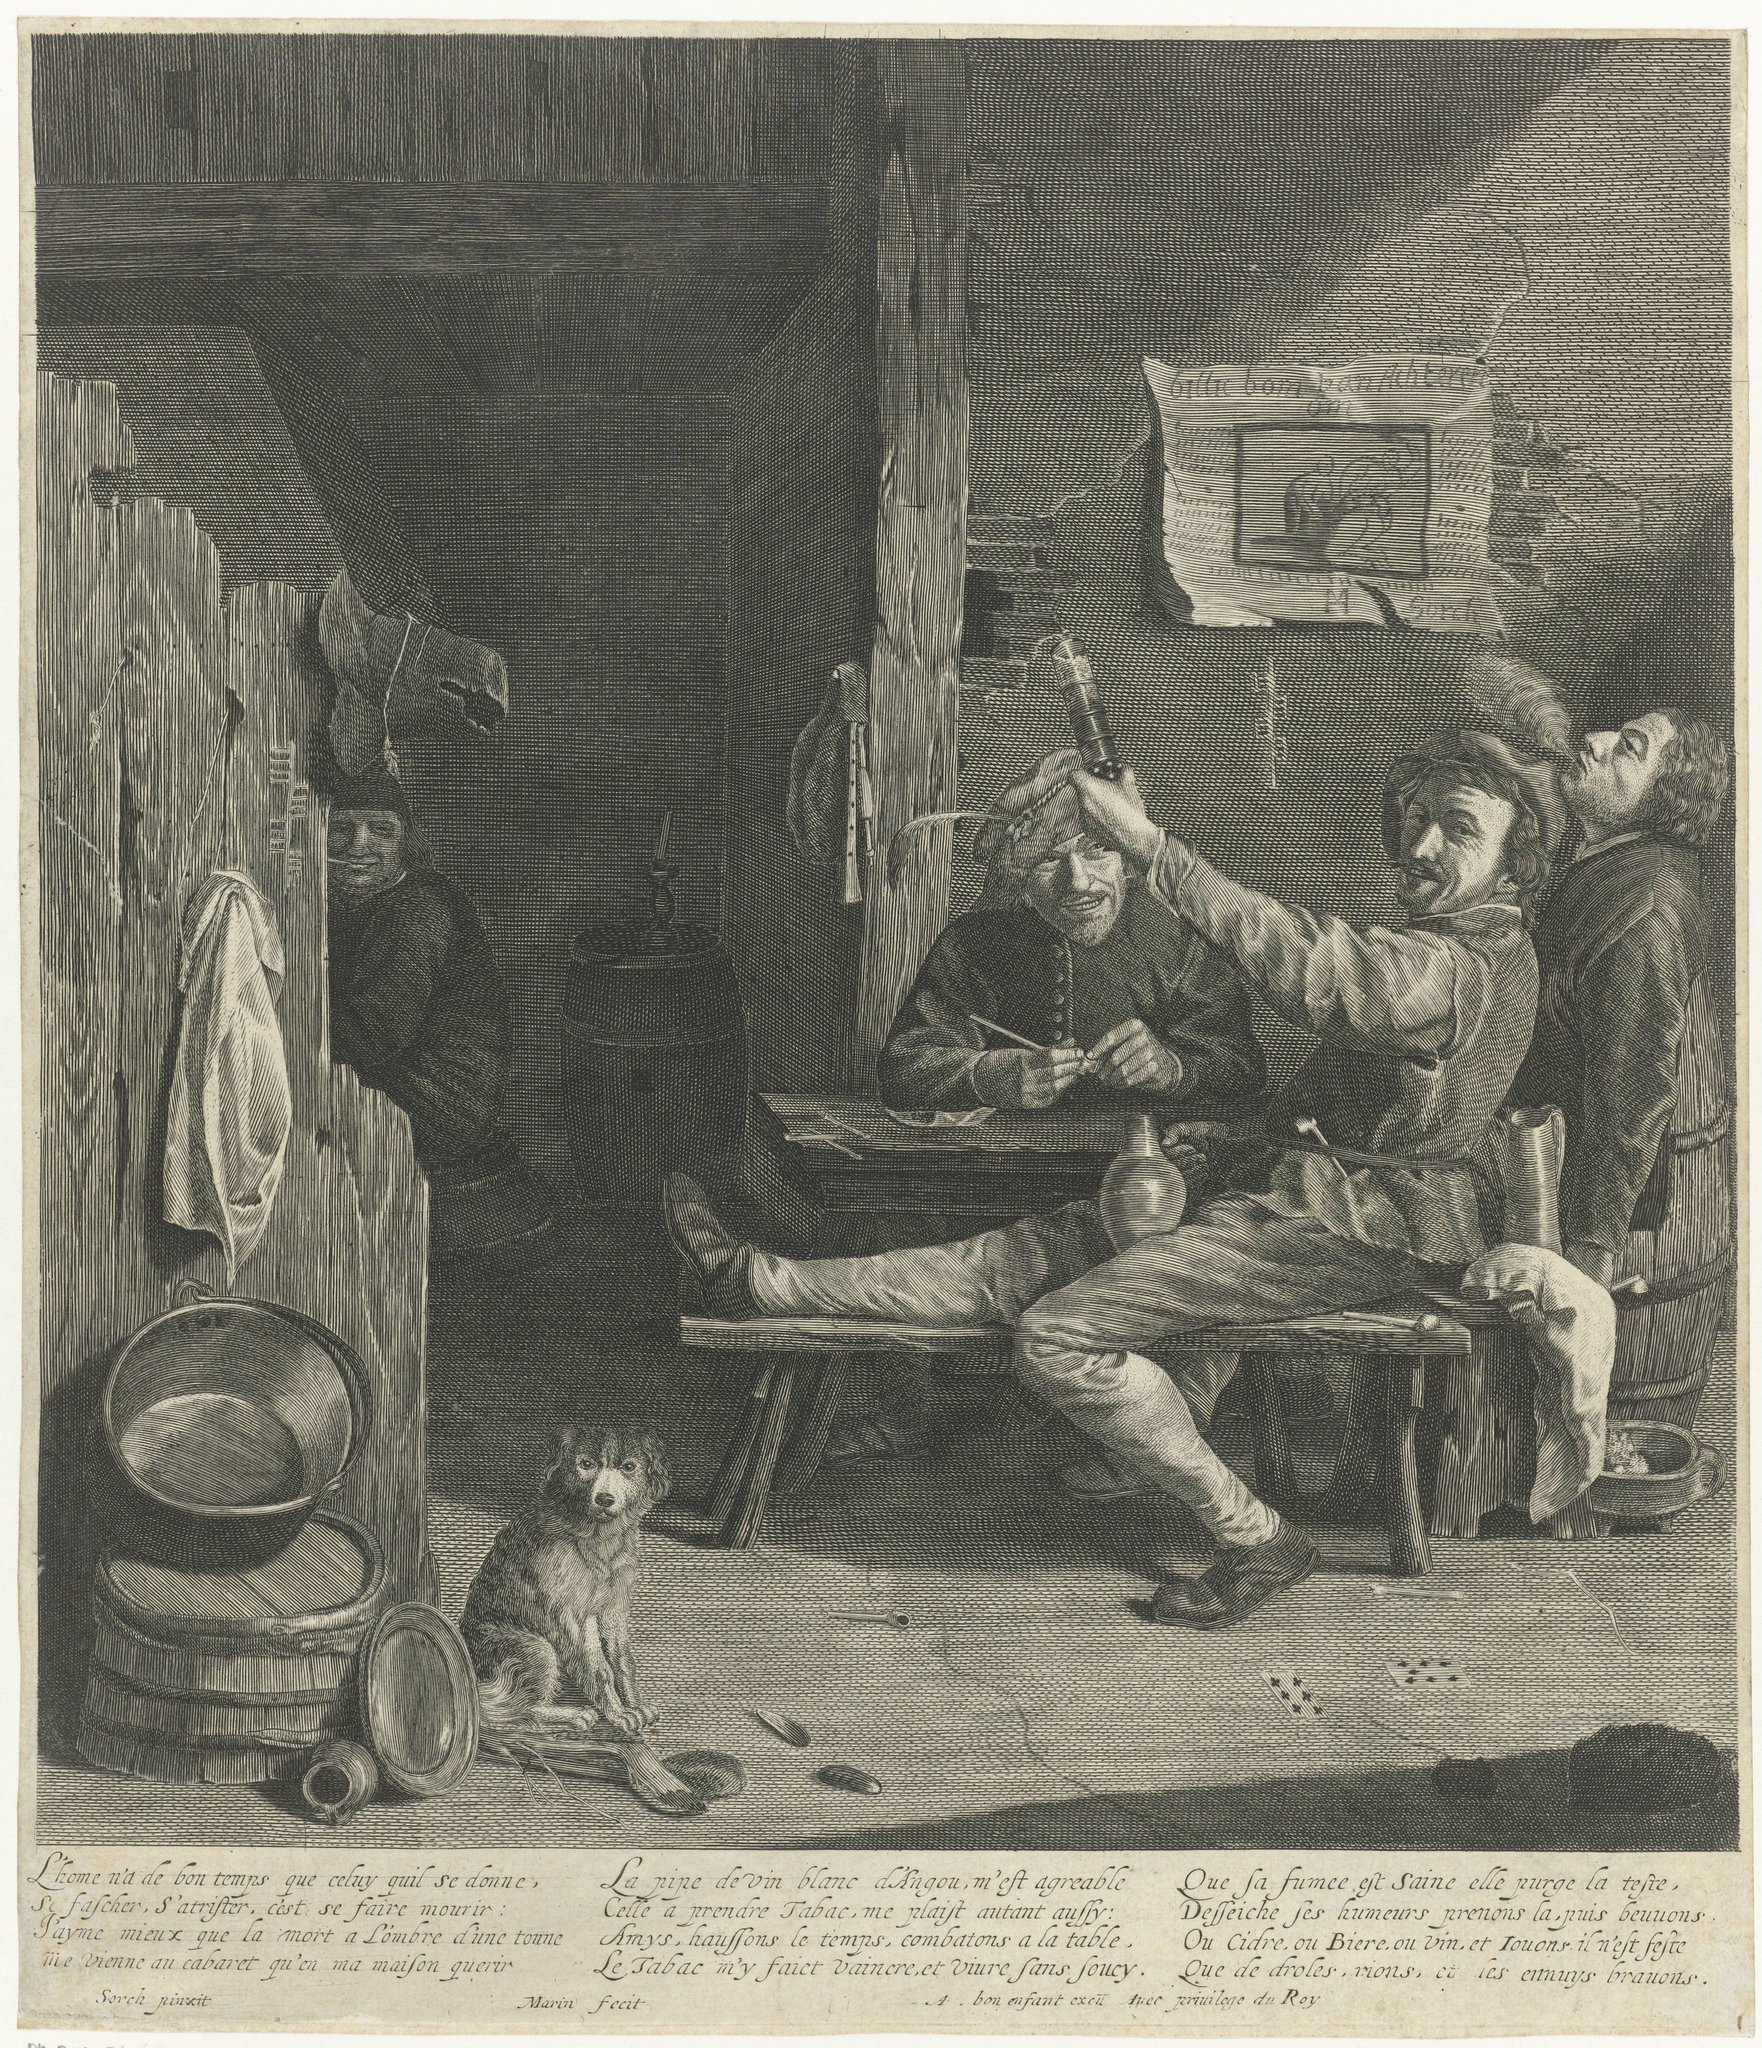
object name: print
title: Herberginterieur met drinkende en rokende heren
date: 1609-1639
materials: paper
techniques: engraving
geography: antwerp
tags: inn, coffee-house, public house, etc., pipe ~ tobacco, drinking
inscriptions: collector's mark: Lugt 11, collector's mark: Lugt 10